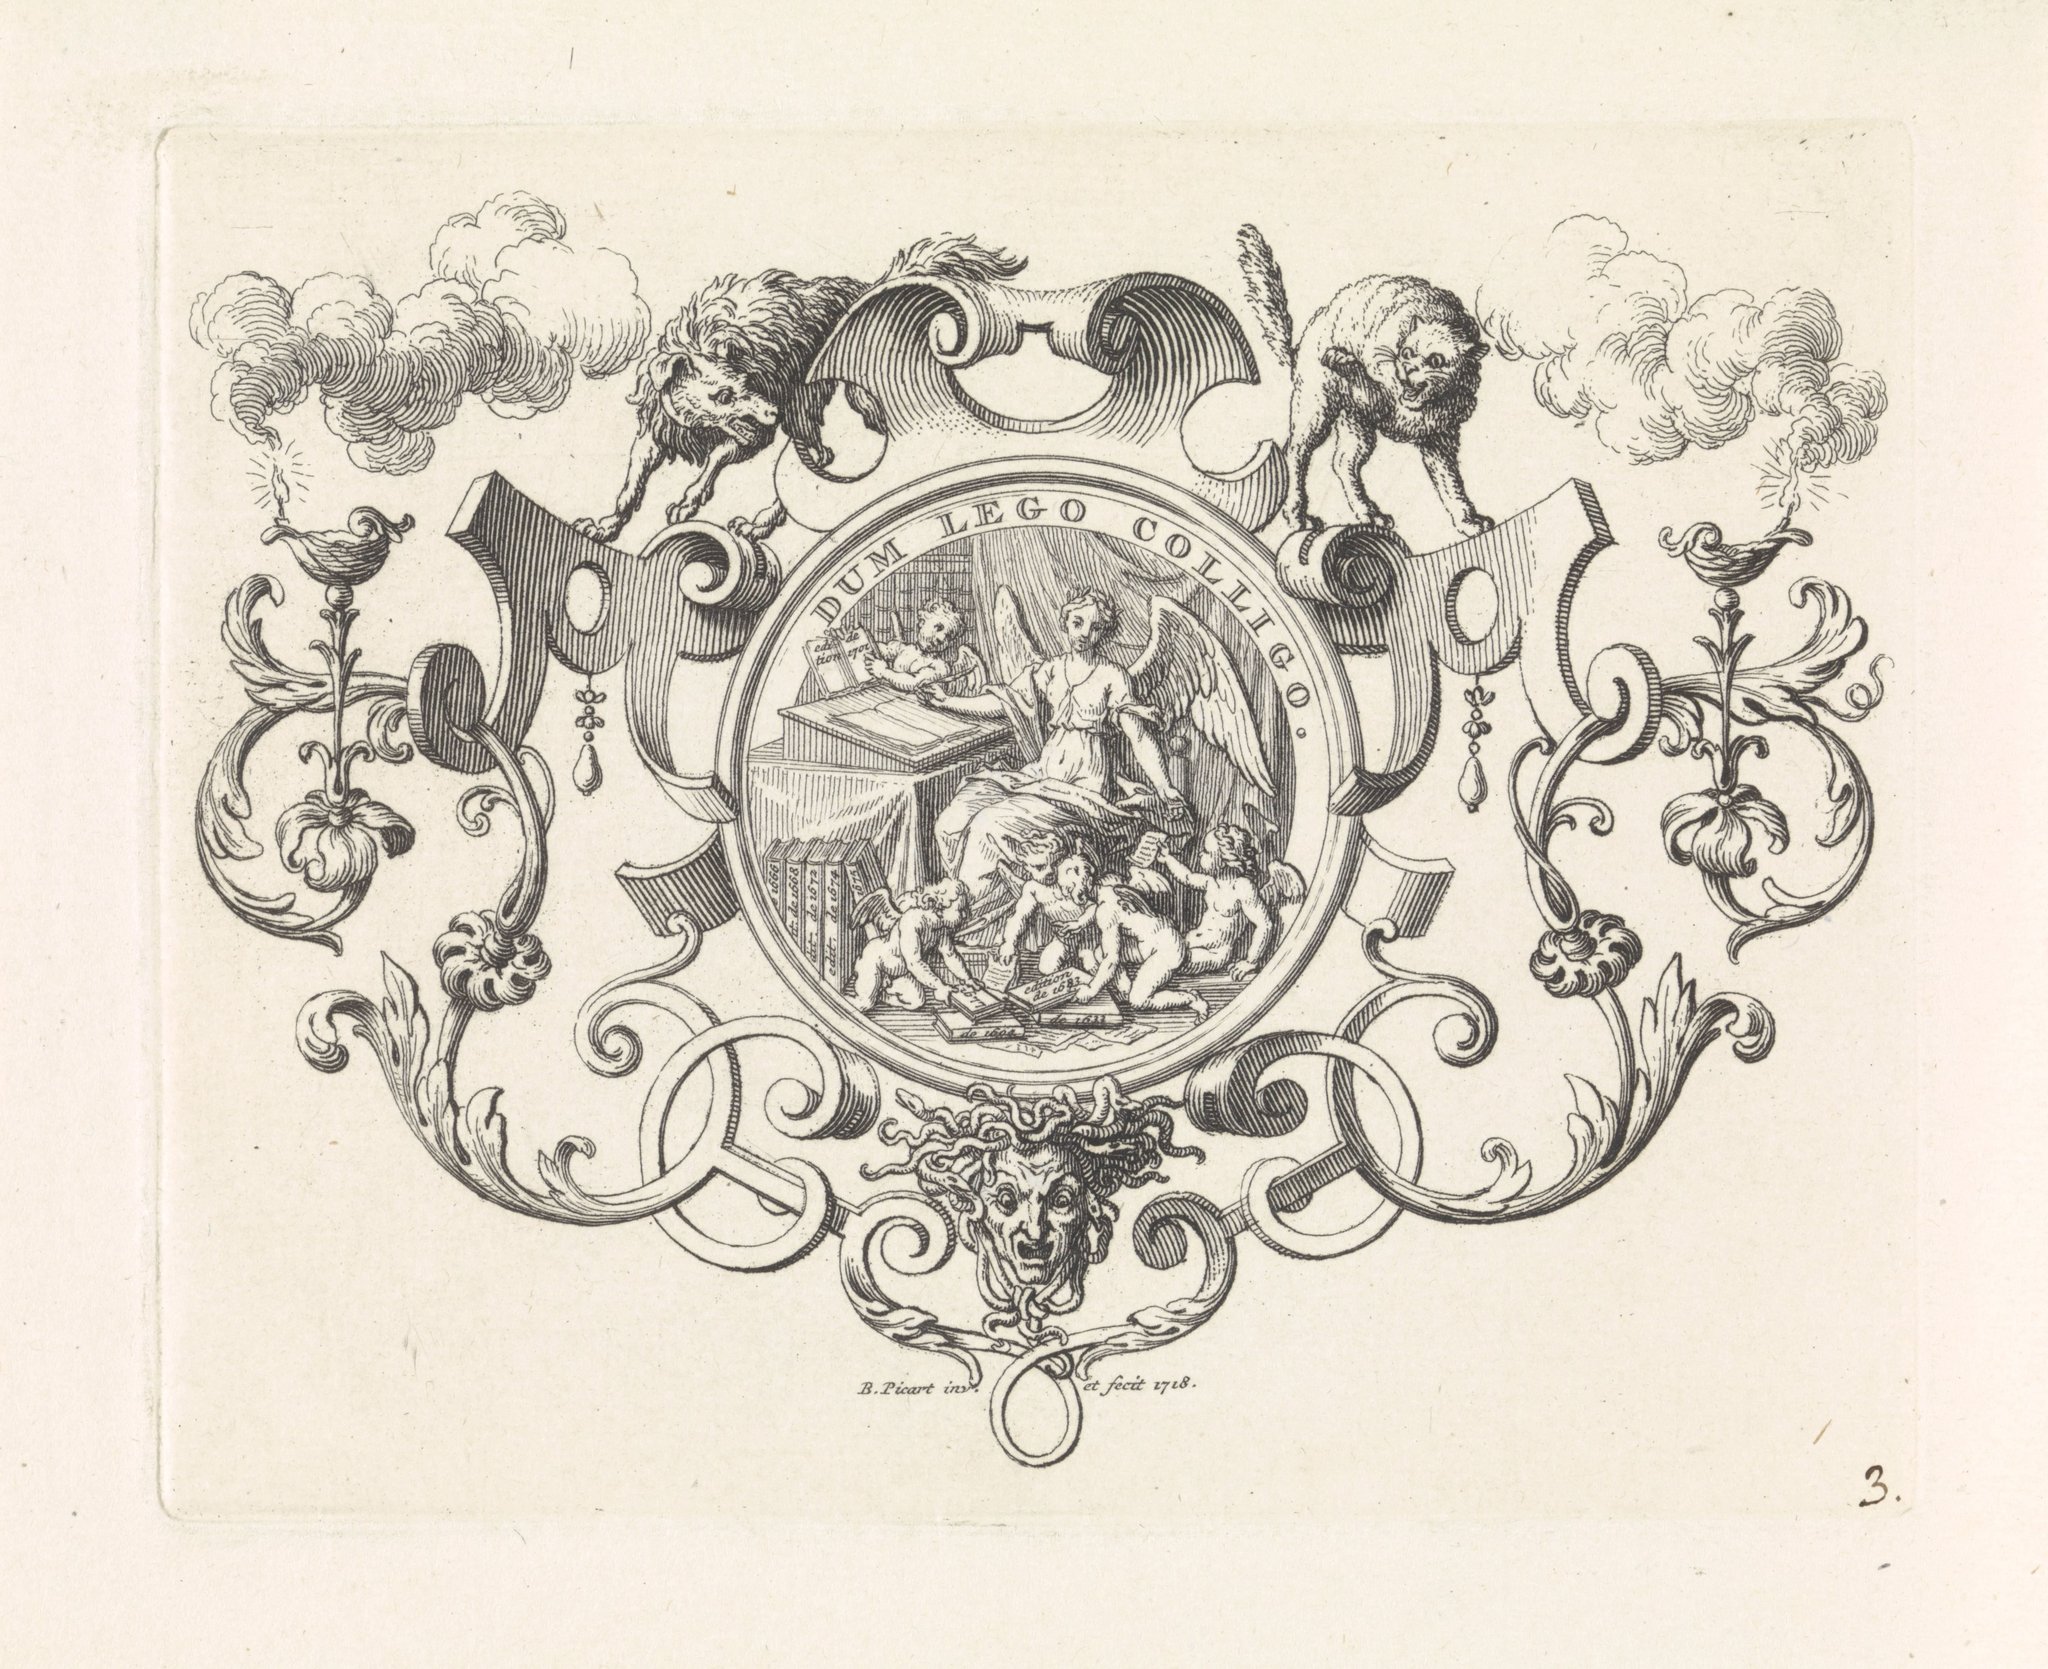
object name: print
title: Medaillon met de personificatie van Geschiedenis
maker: bernard picart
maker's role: draughtsman, print maker, publisher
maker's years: 1673-1733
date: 1718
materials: paper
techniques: engraving, etching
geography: amsterdam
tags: ornaments ~ art, book, 'historia'; 'historia' (ripa), gorgoneion, head of medusa, dog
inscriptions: number: ‘3.’, collector's mark: Lugt 2233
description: Medaillon met de personificatie van Geschiedenis aan een schrijftafel omringd door putti met de verschillende edities van het werk van Boileau. Rondom de voorstelling het devies: Dum Lego Colligo. Rondom ornamenten met een hond en een kat.